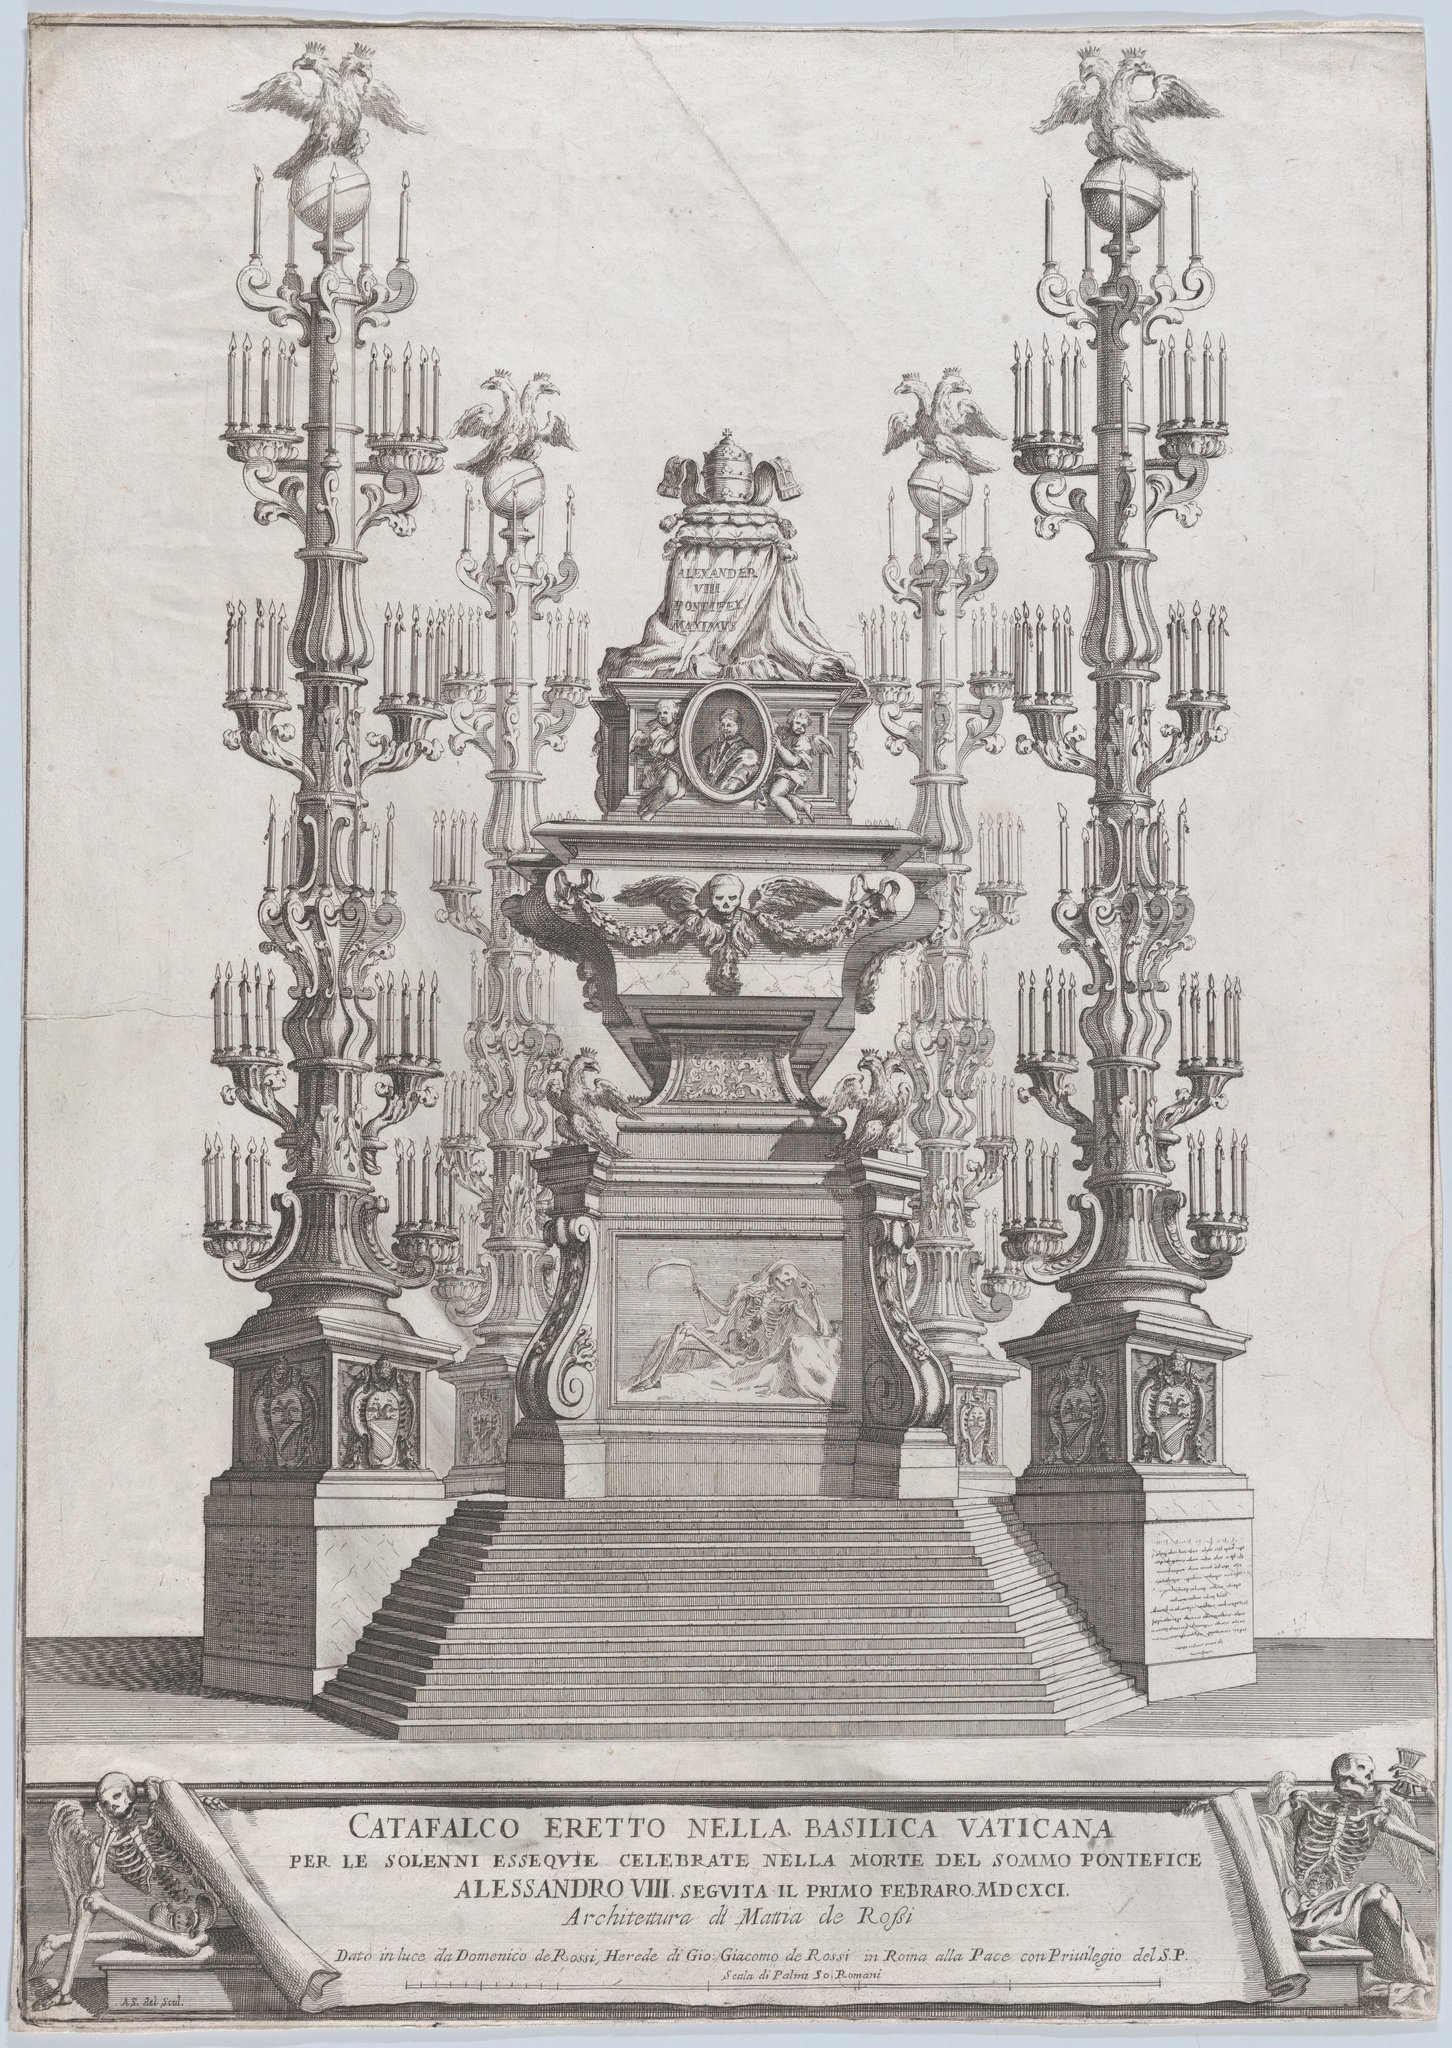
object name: print, fete, ornament architecture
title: Catafalco Eretto Nella Basilica Vaticana ...per Alessandro VIII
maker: alessandro specchi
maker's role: artist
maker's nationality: italian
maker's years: 1668-1729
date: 1691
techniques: engraving, etching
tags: skeletons,candles